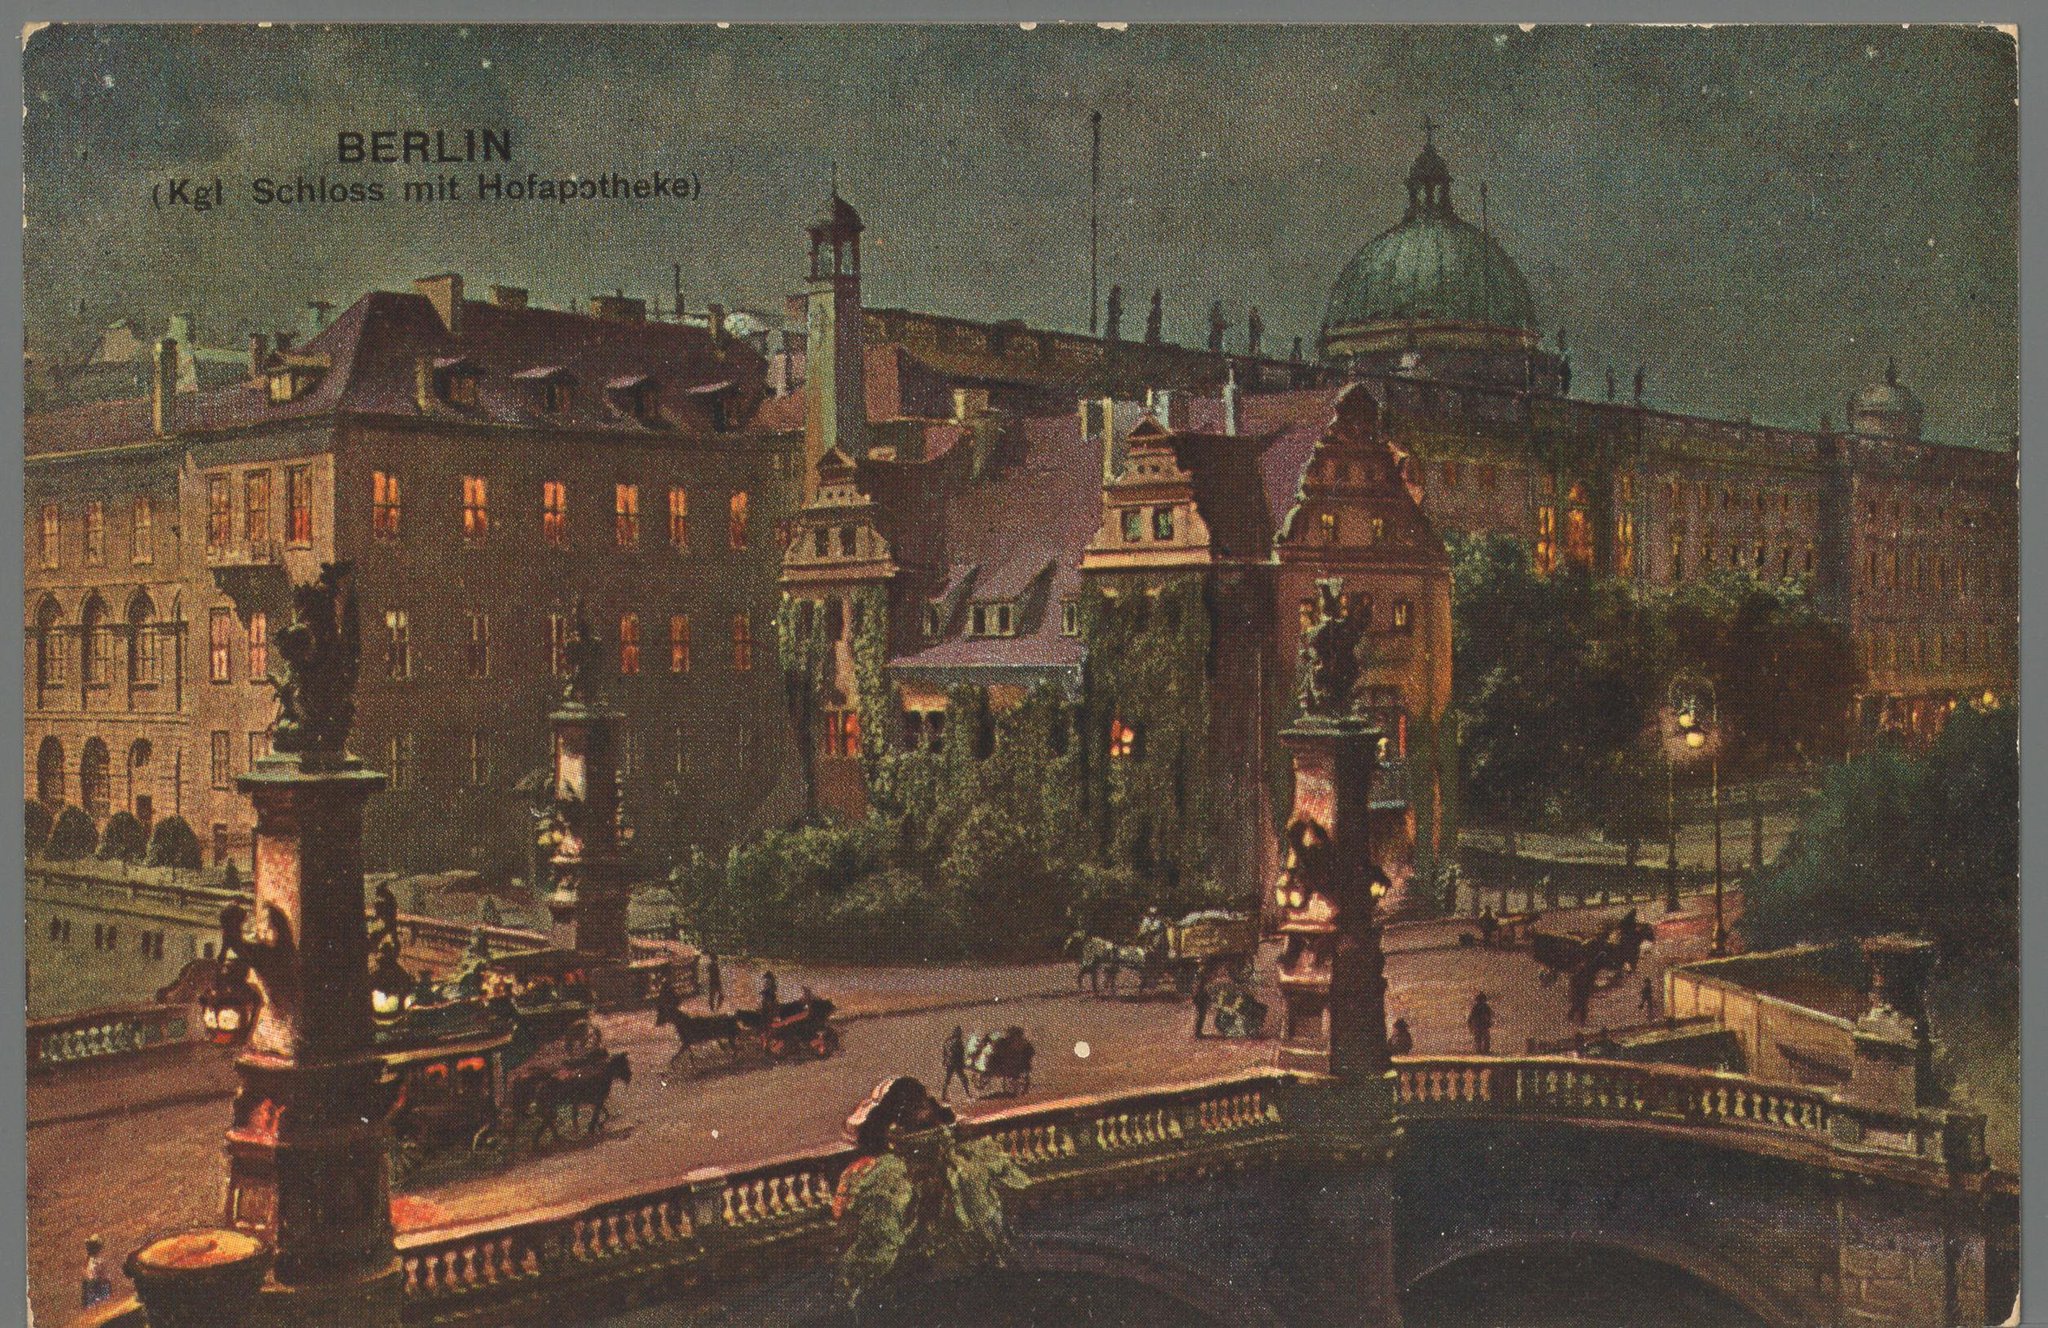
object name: photomechanical print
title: Künstler-Aquarell-Karte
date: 1905-1909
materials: cardboard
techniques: writing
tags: castle, pharmacy, pharmaceutics, bridge in city across river, canal, etc.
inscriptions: monogram: ‘P.F.B.’